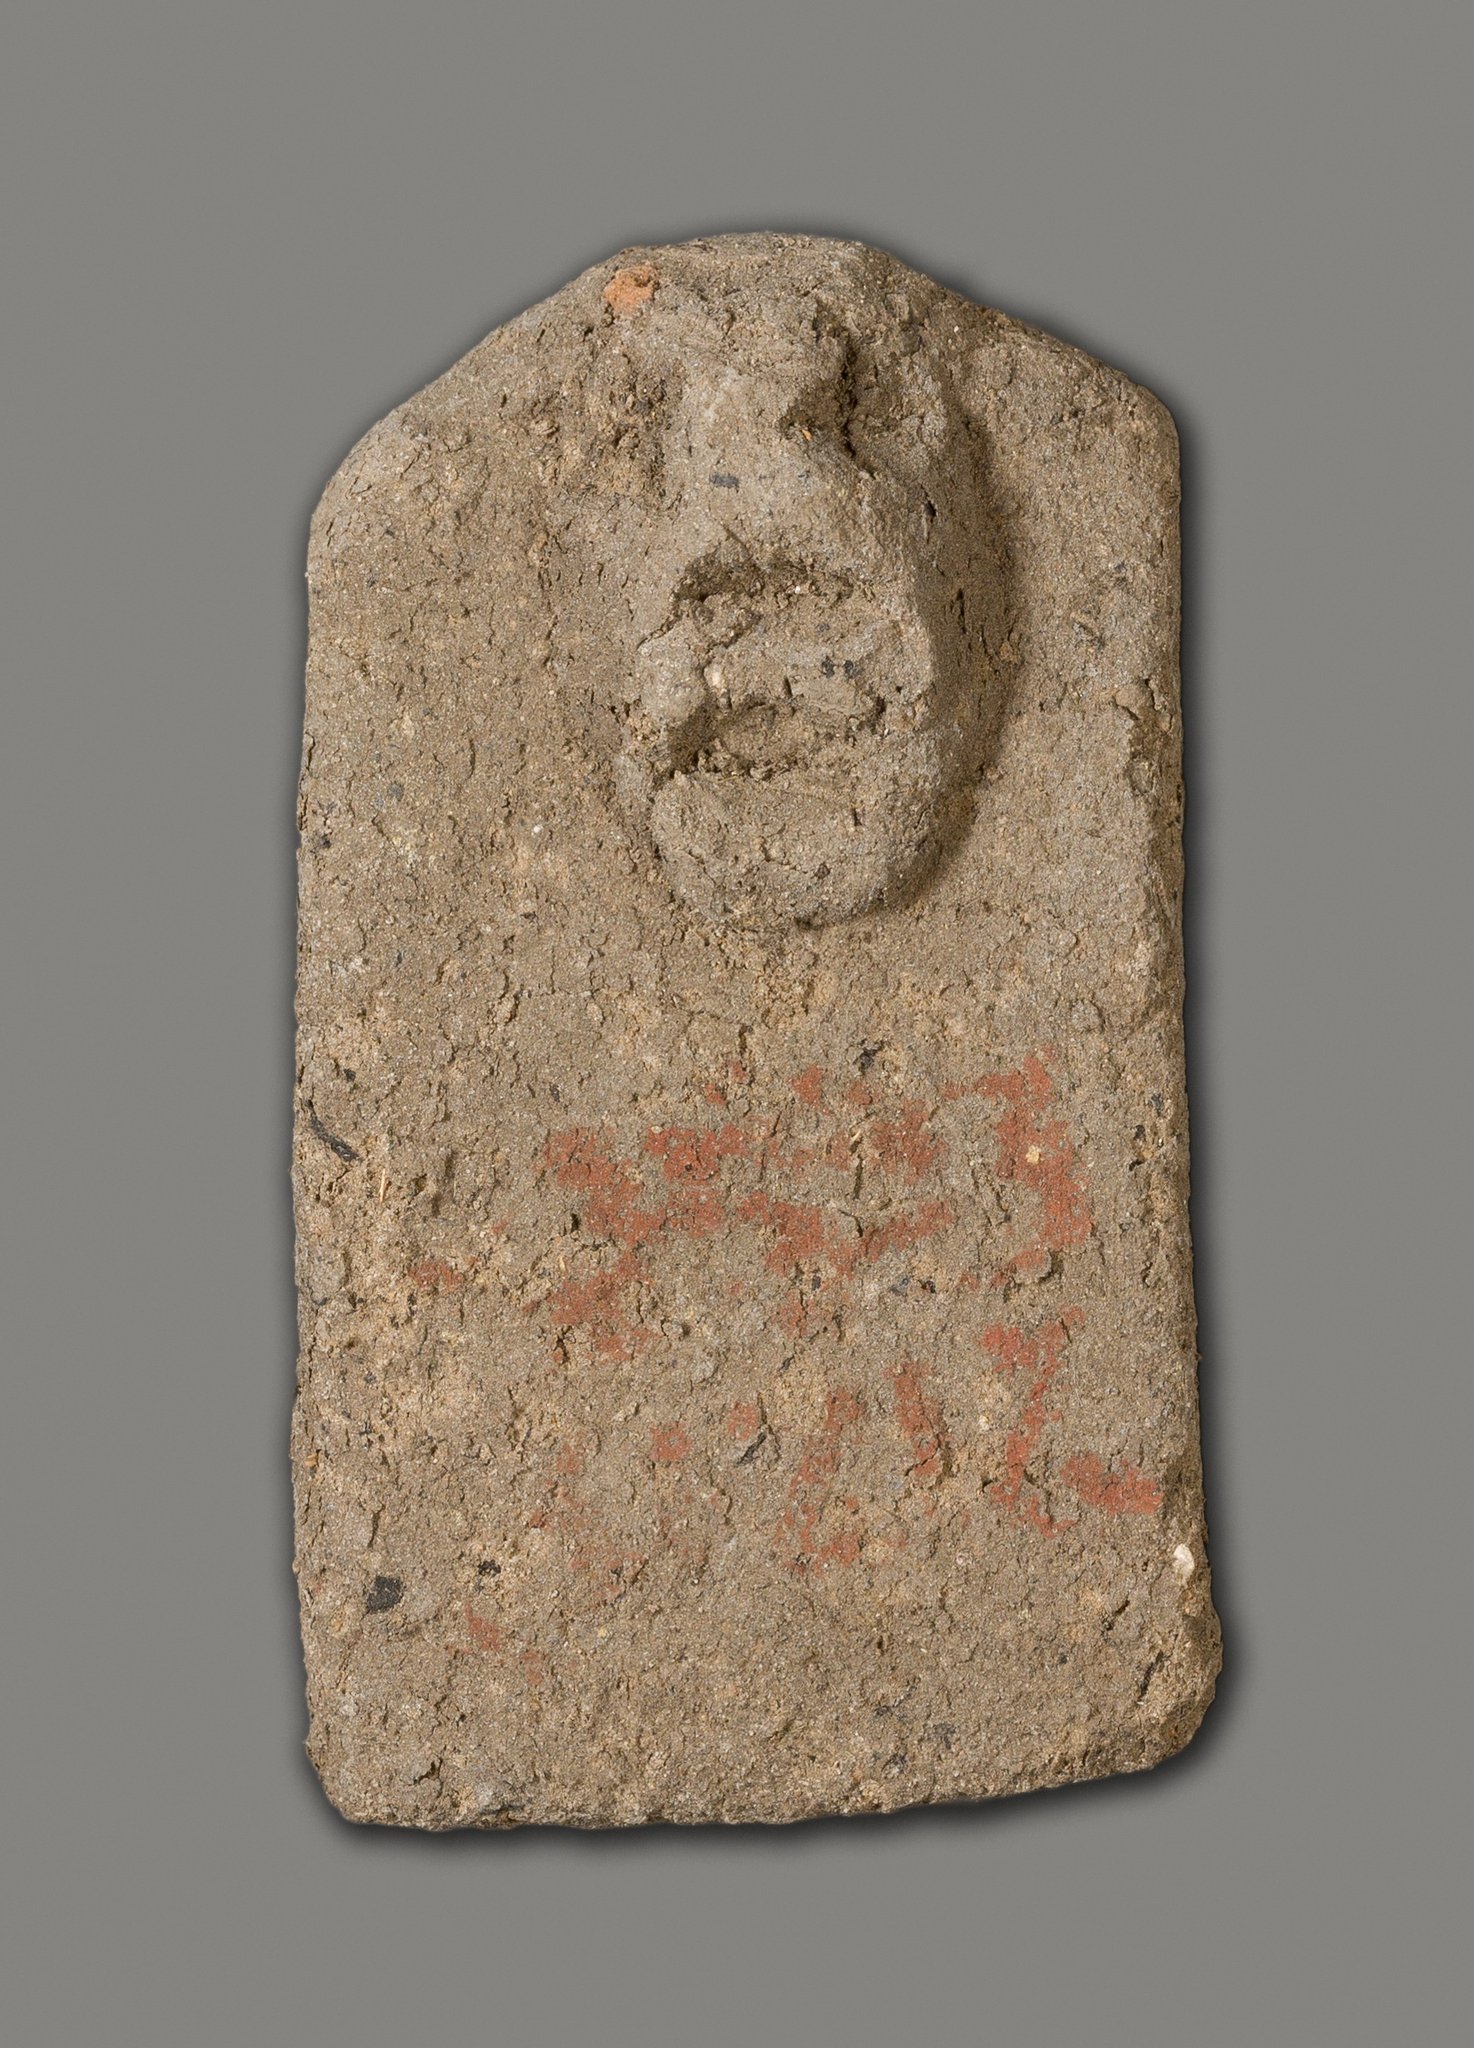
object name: figure, magical, execration, tablet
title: Magical Figure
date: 1802-1550 BCE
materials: clay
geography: egypt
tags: faces